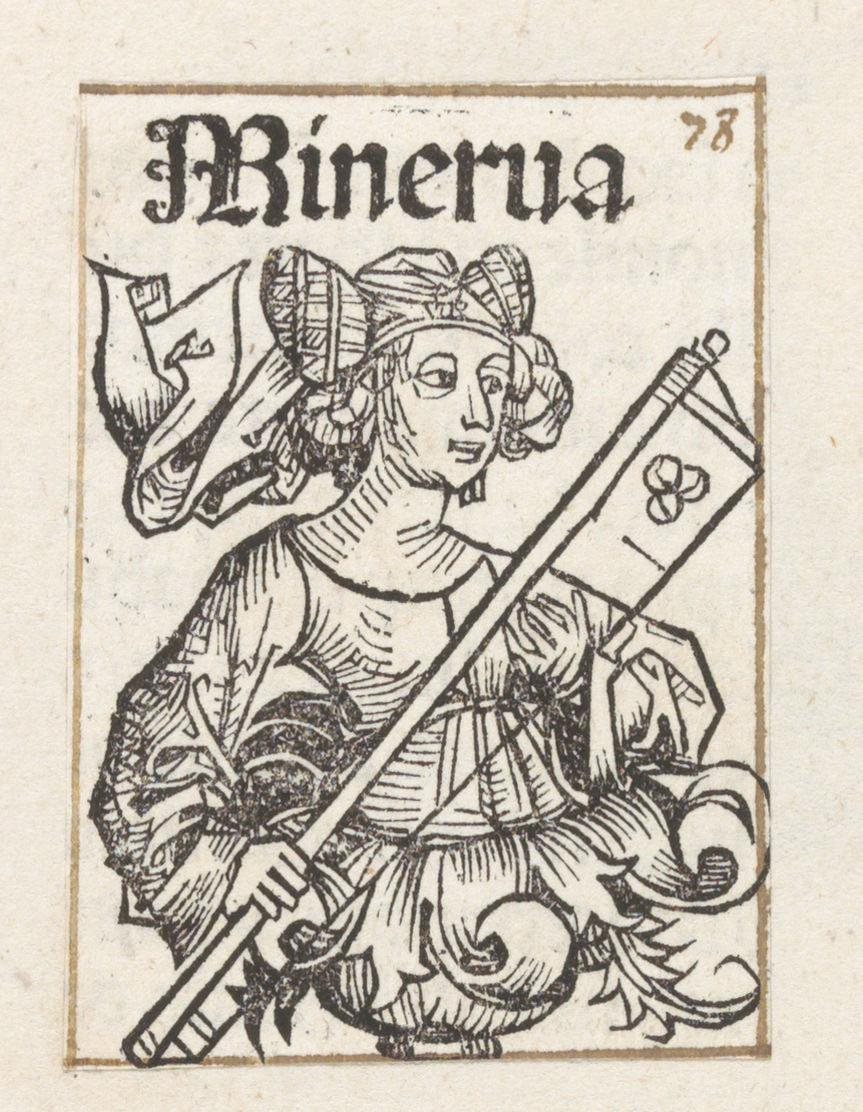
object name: book illustration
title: Minerva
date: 1493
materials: paper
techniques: letterpress printing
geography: nuremberg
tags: (story of) minerva (pallas, athena)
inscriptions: inscription: ‘78’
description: Een bloemkelk met een vrouw, naar rechts gekeerd. Ze heeft een net over haar haar en heeft mogelijk een spintol vast. De tekst identificeert haar als Minerva, dochter van Jupiter. De prent maakt deel uit van een album.